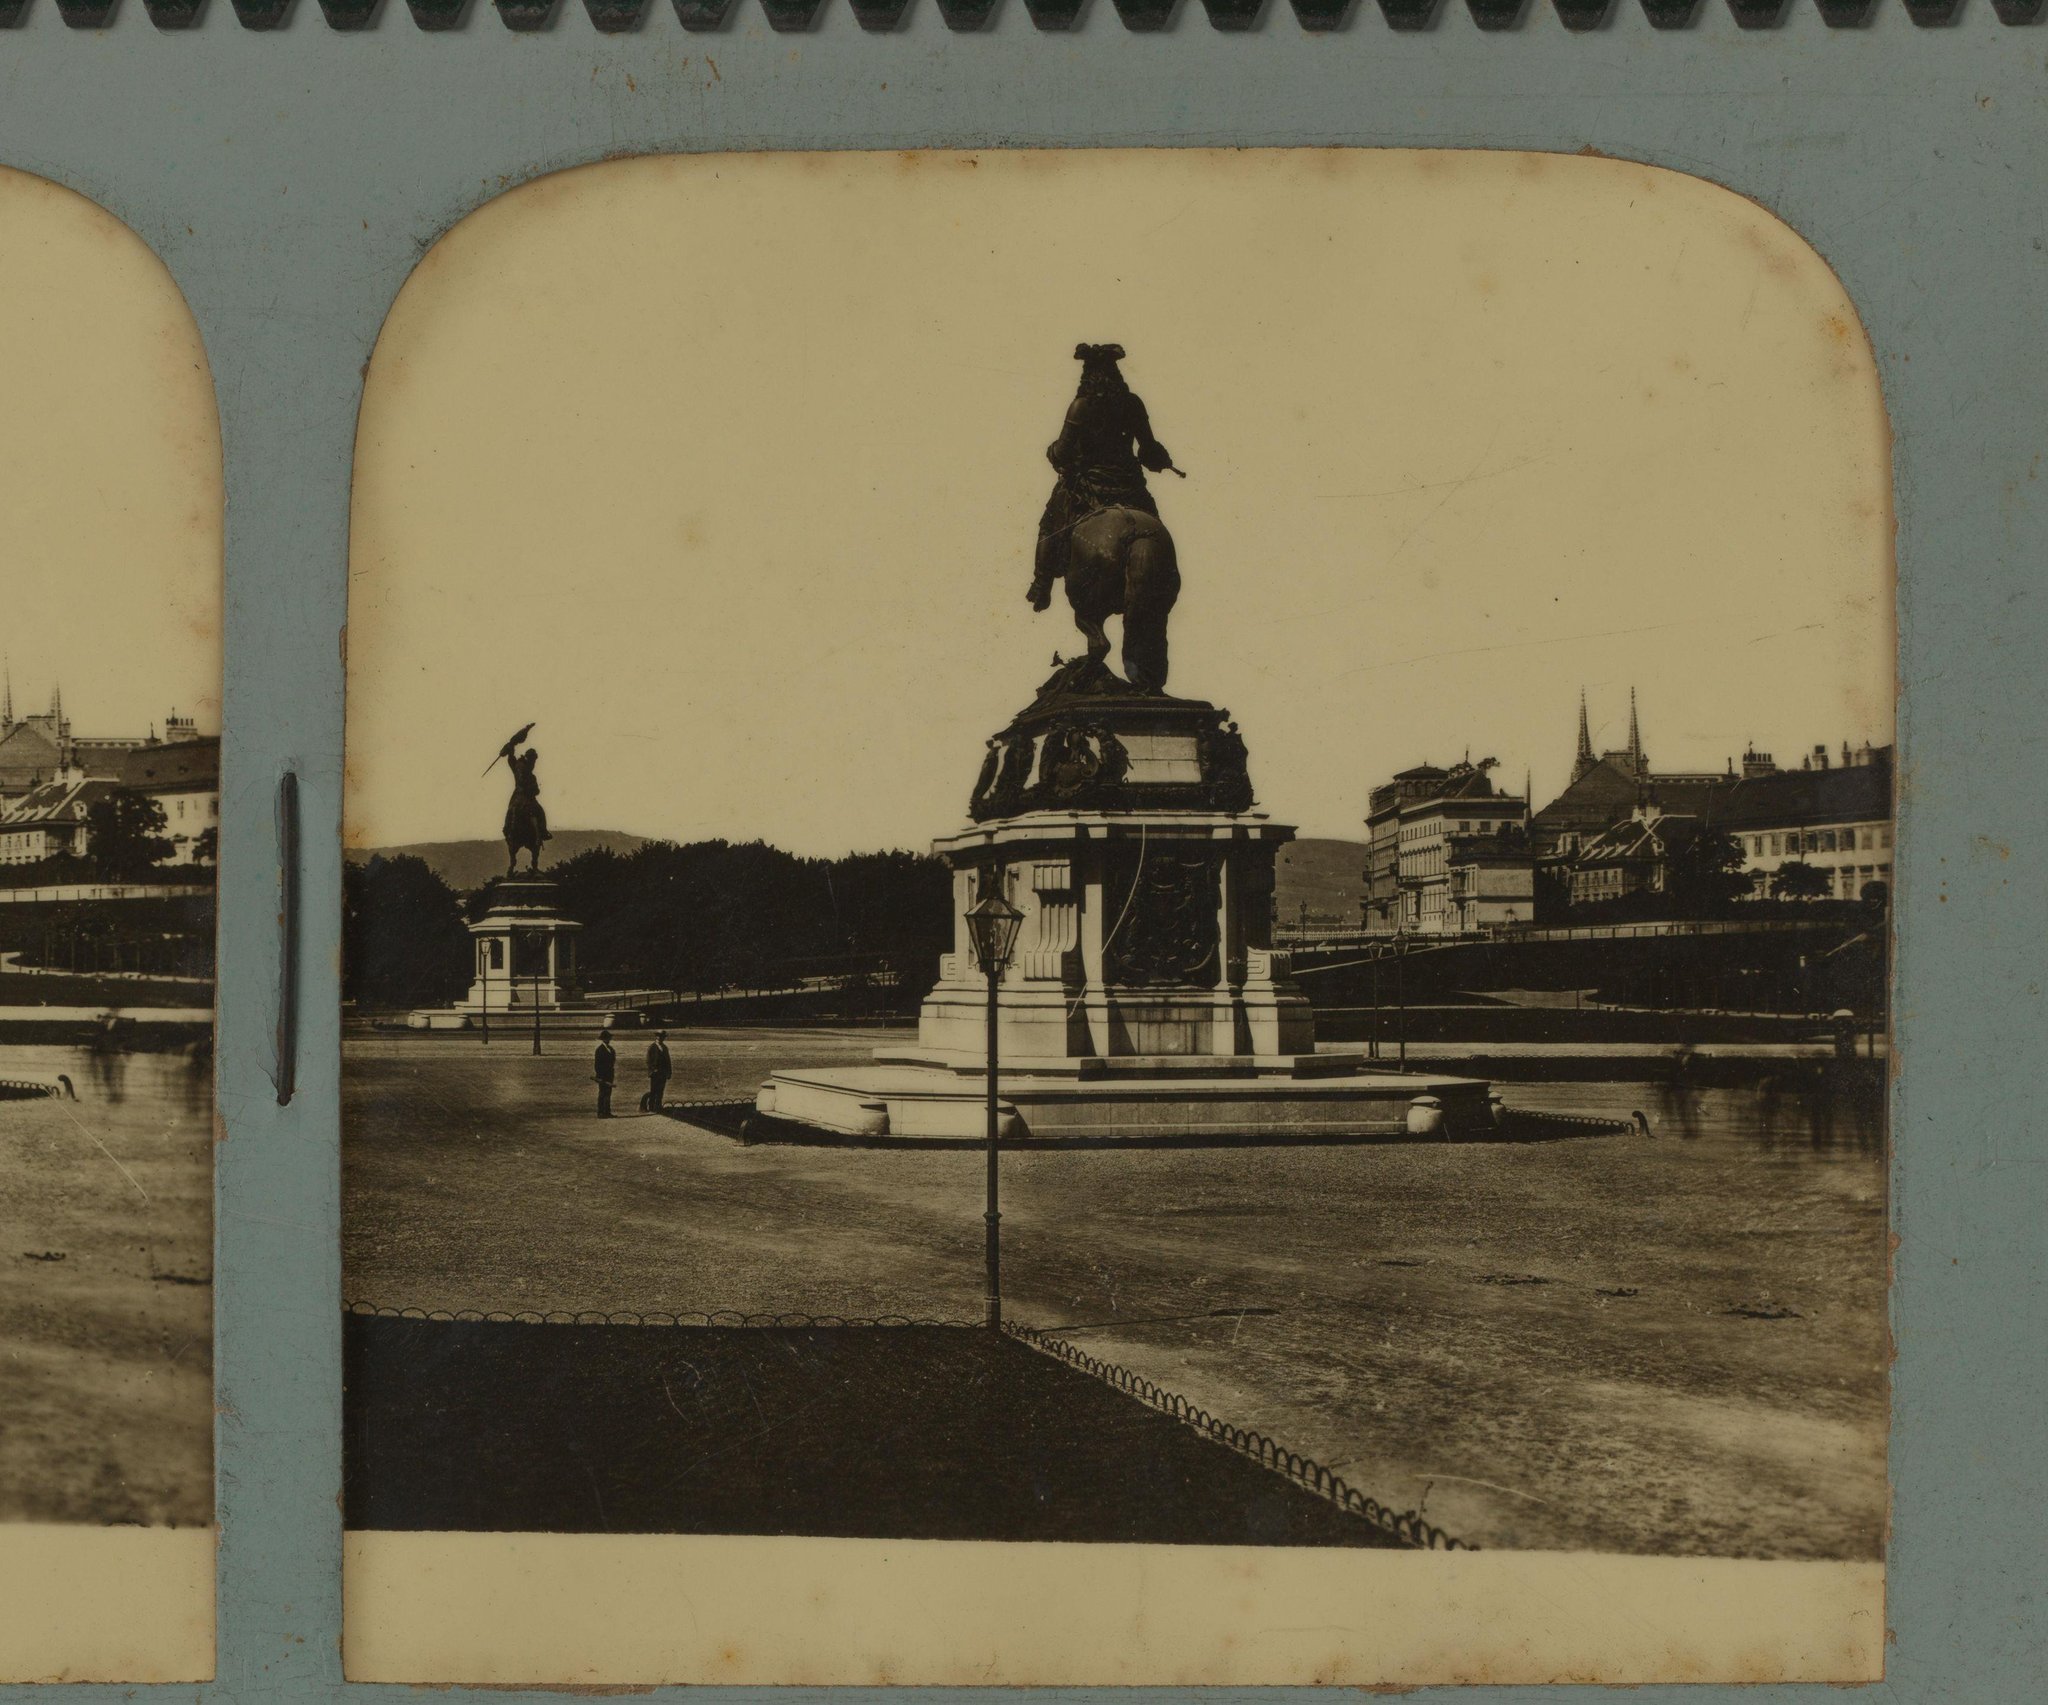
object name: stereograph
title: Ruiterstandbeelden van aartshertog Karel en Eugenius van Savoye op het Heldenplatz in Wenen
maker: Anonymous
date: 1900-1940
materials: cardboard, film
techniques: black and white slide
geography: vienna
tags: charles v (holy roman emperor and king of spain), paris, vienna, eugenius van savoye, square, place, circus, etc., equestrian statue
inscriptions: number: ‘1510.’